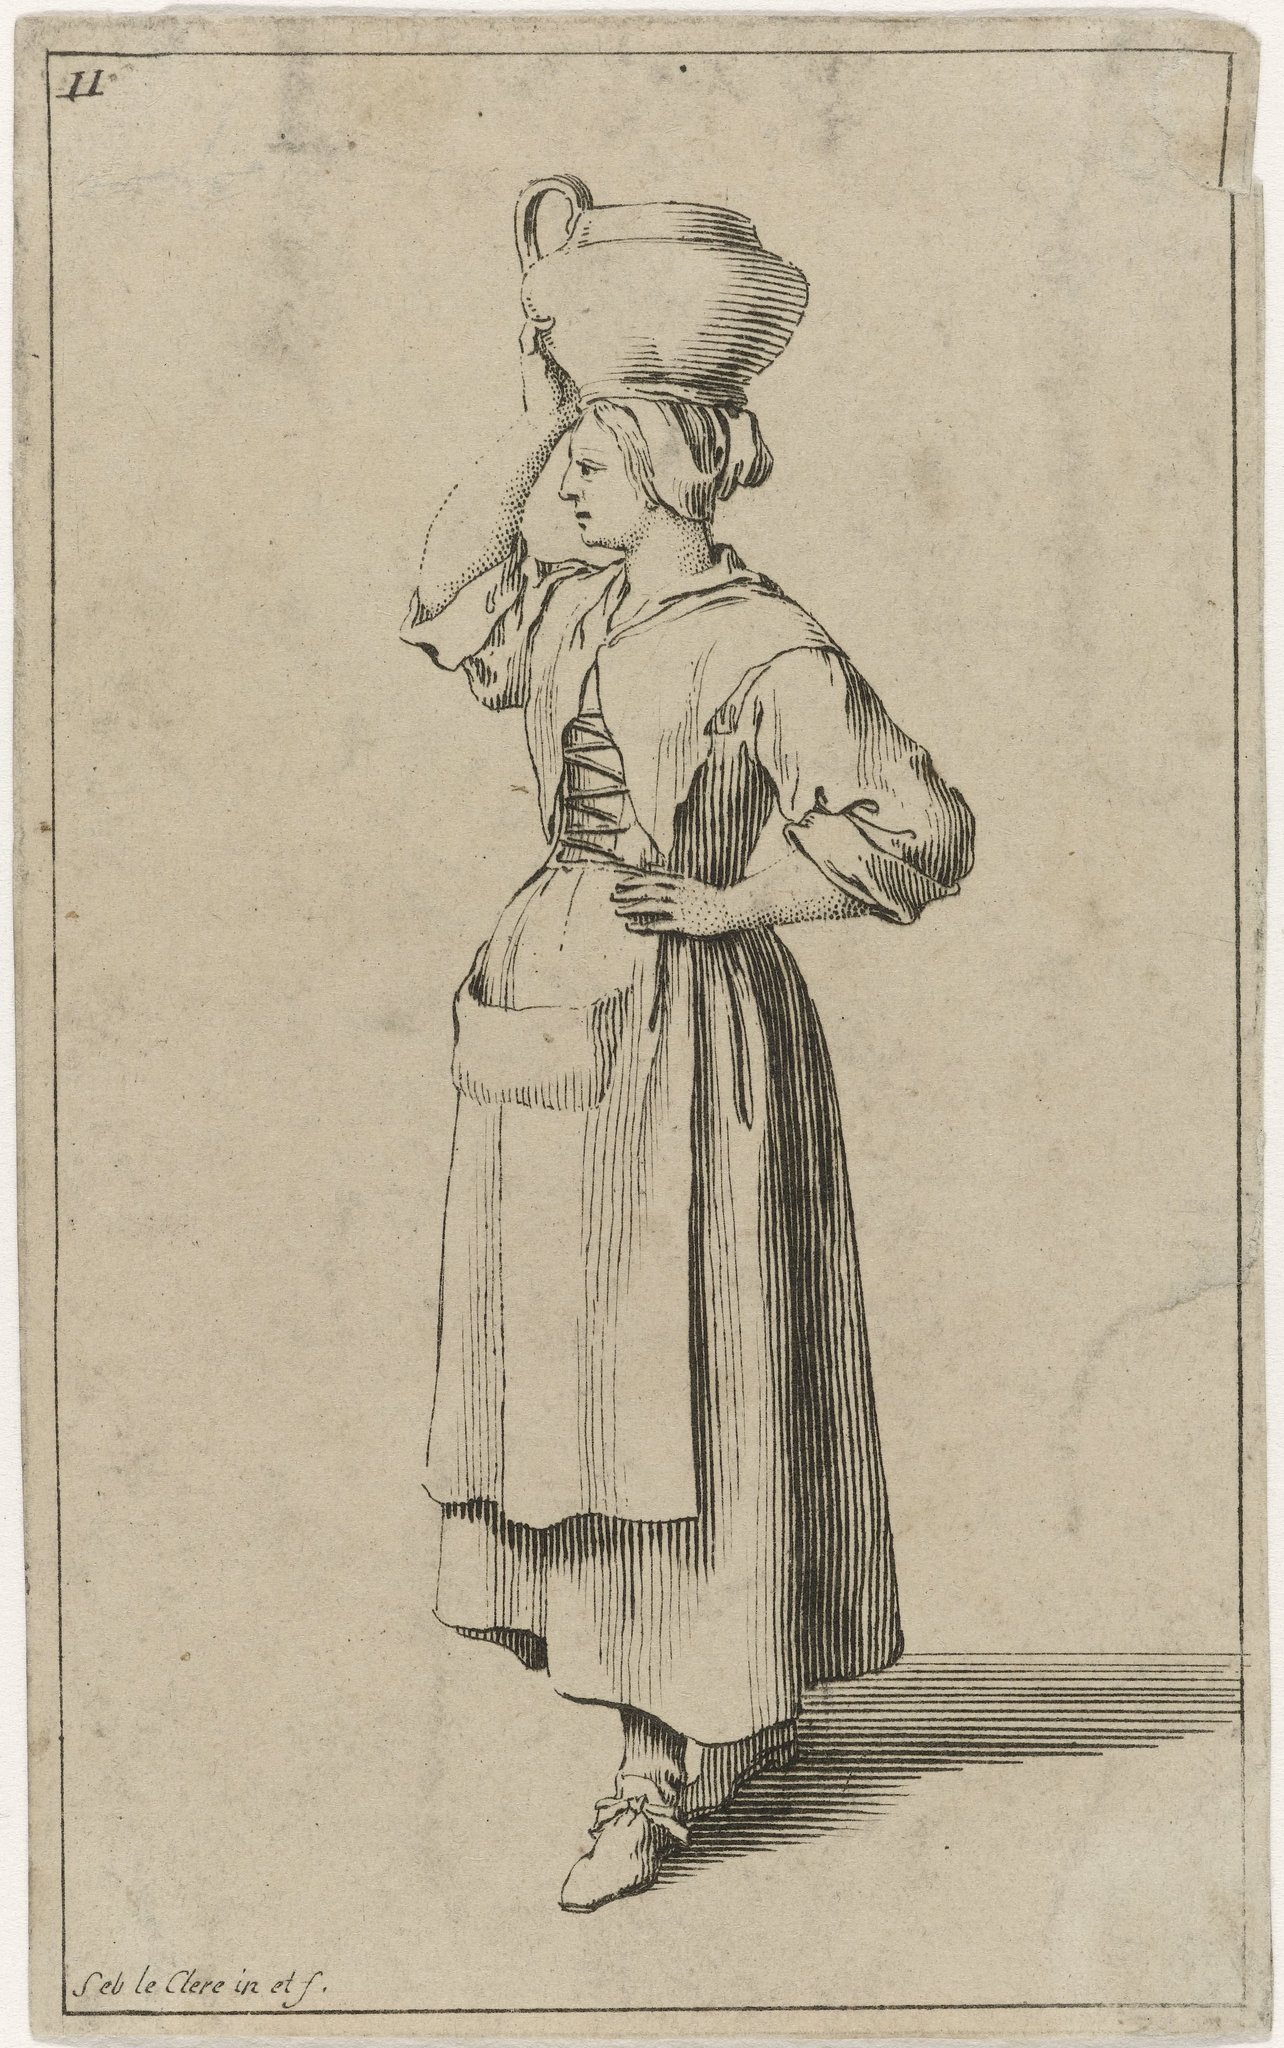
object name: costume print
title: Melkmeid met kruik op het hoofd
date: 1685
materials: paper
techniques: etching